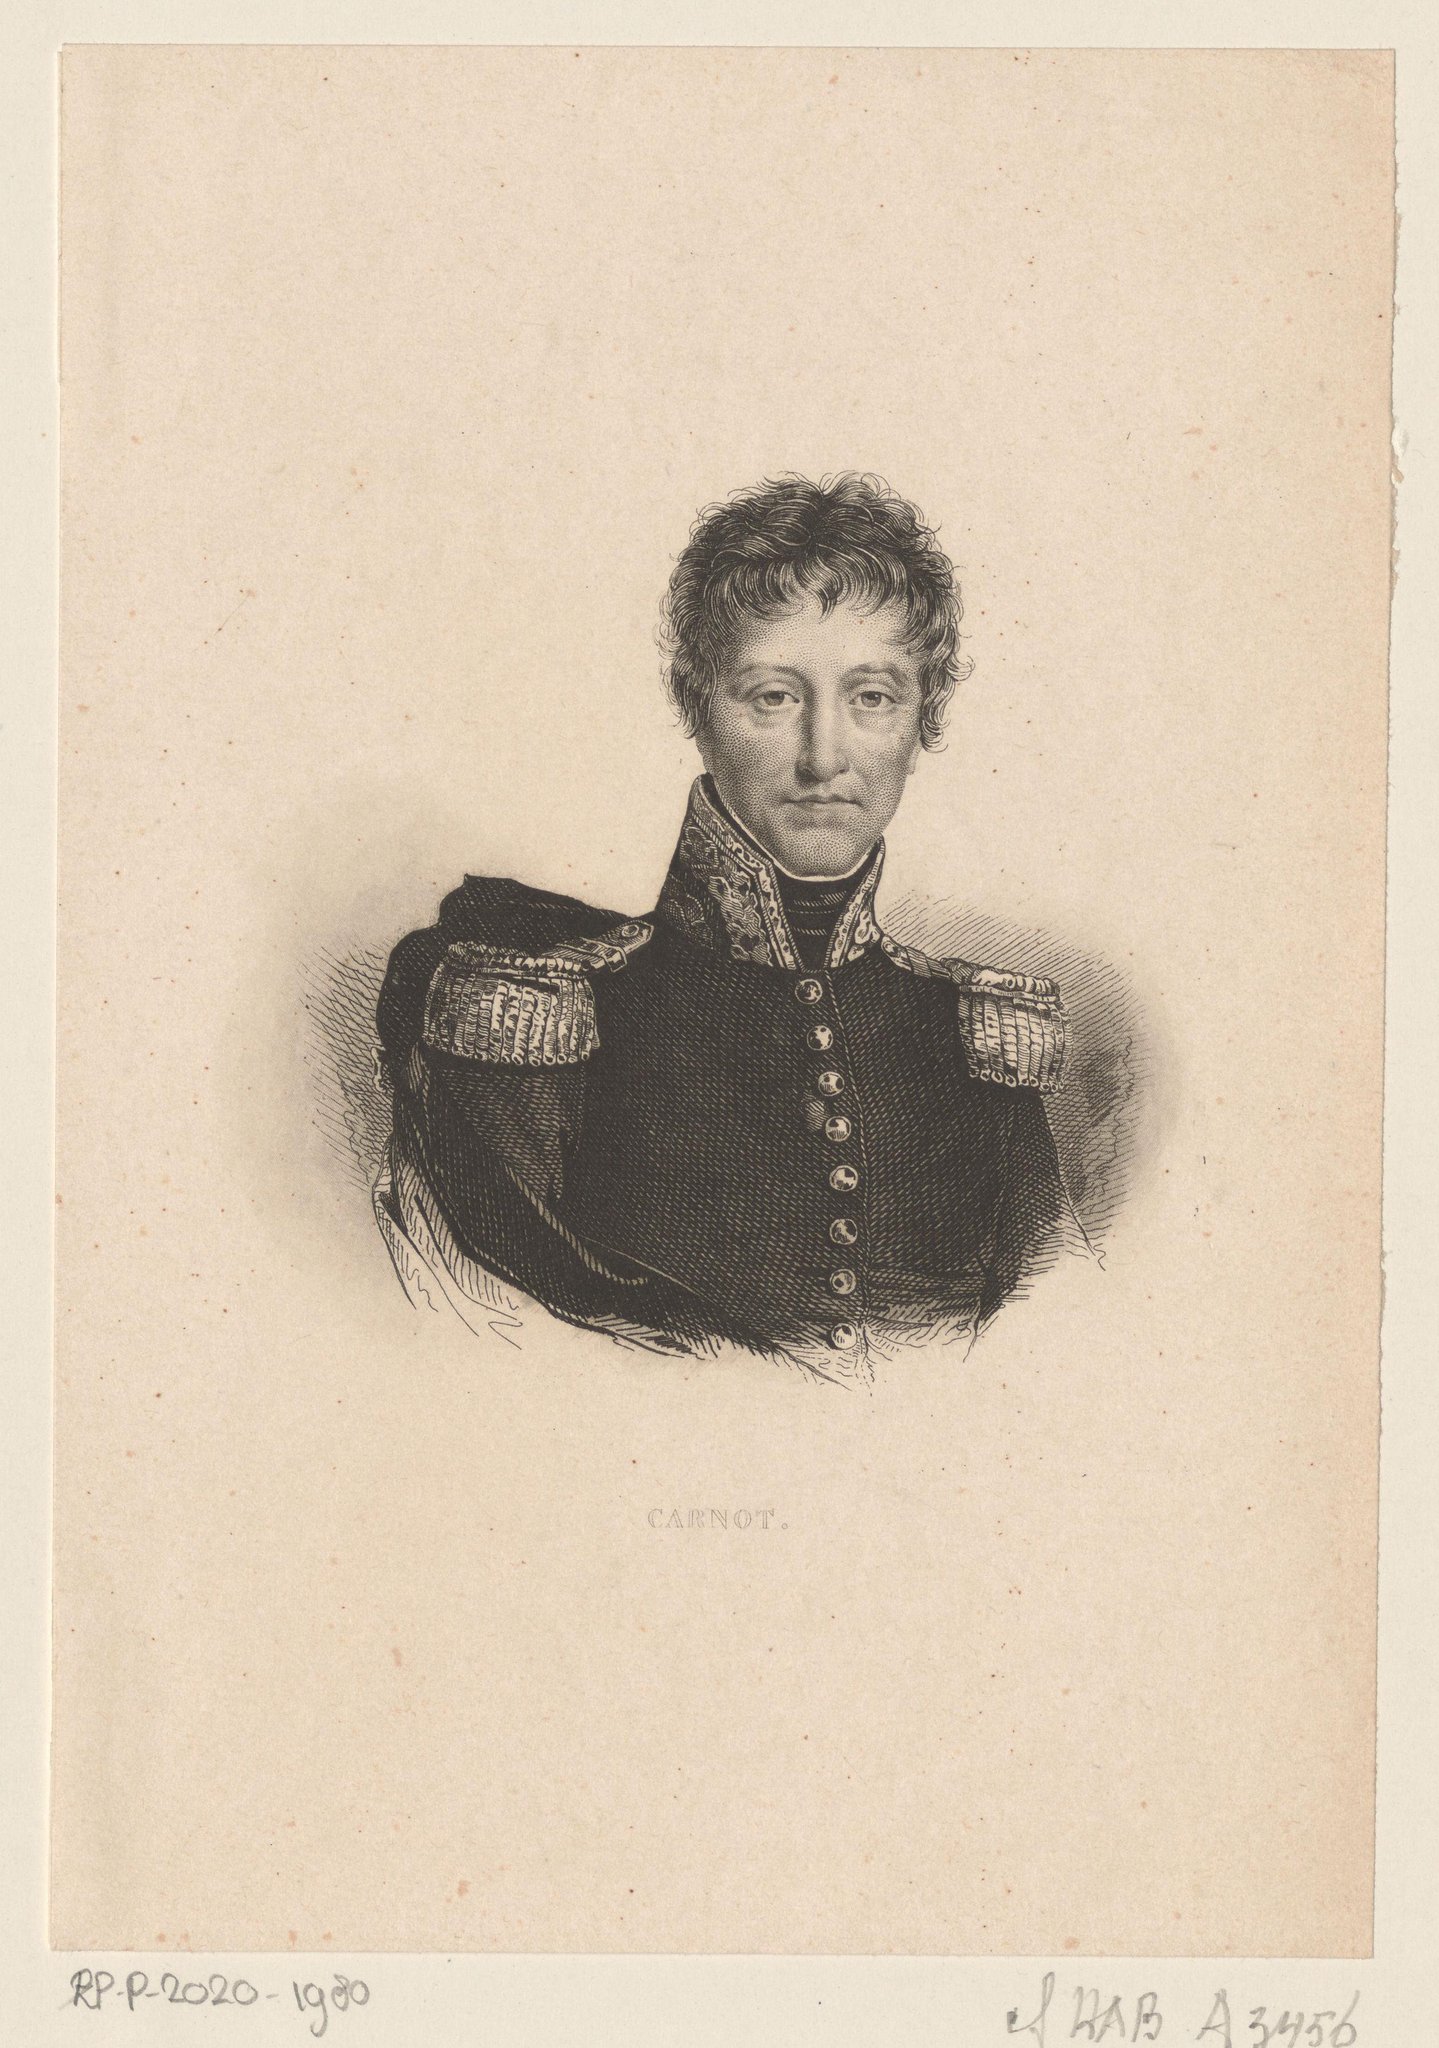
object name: print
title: Portret van Lazare Carnot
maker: Anonymous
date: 1771-1850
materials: paper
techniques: engraving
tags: historical persons